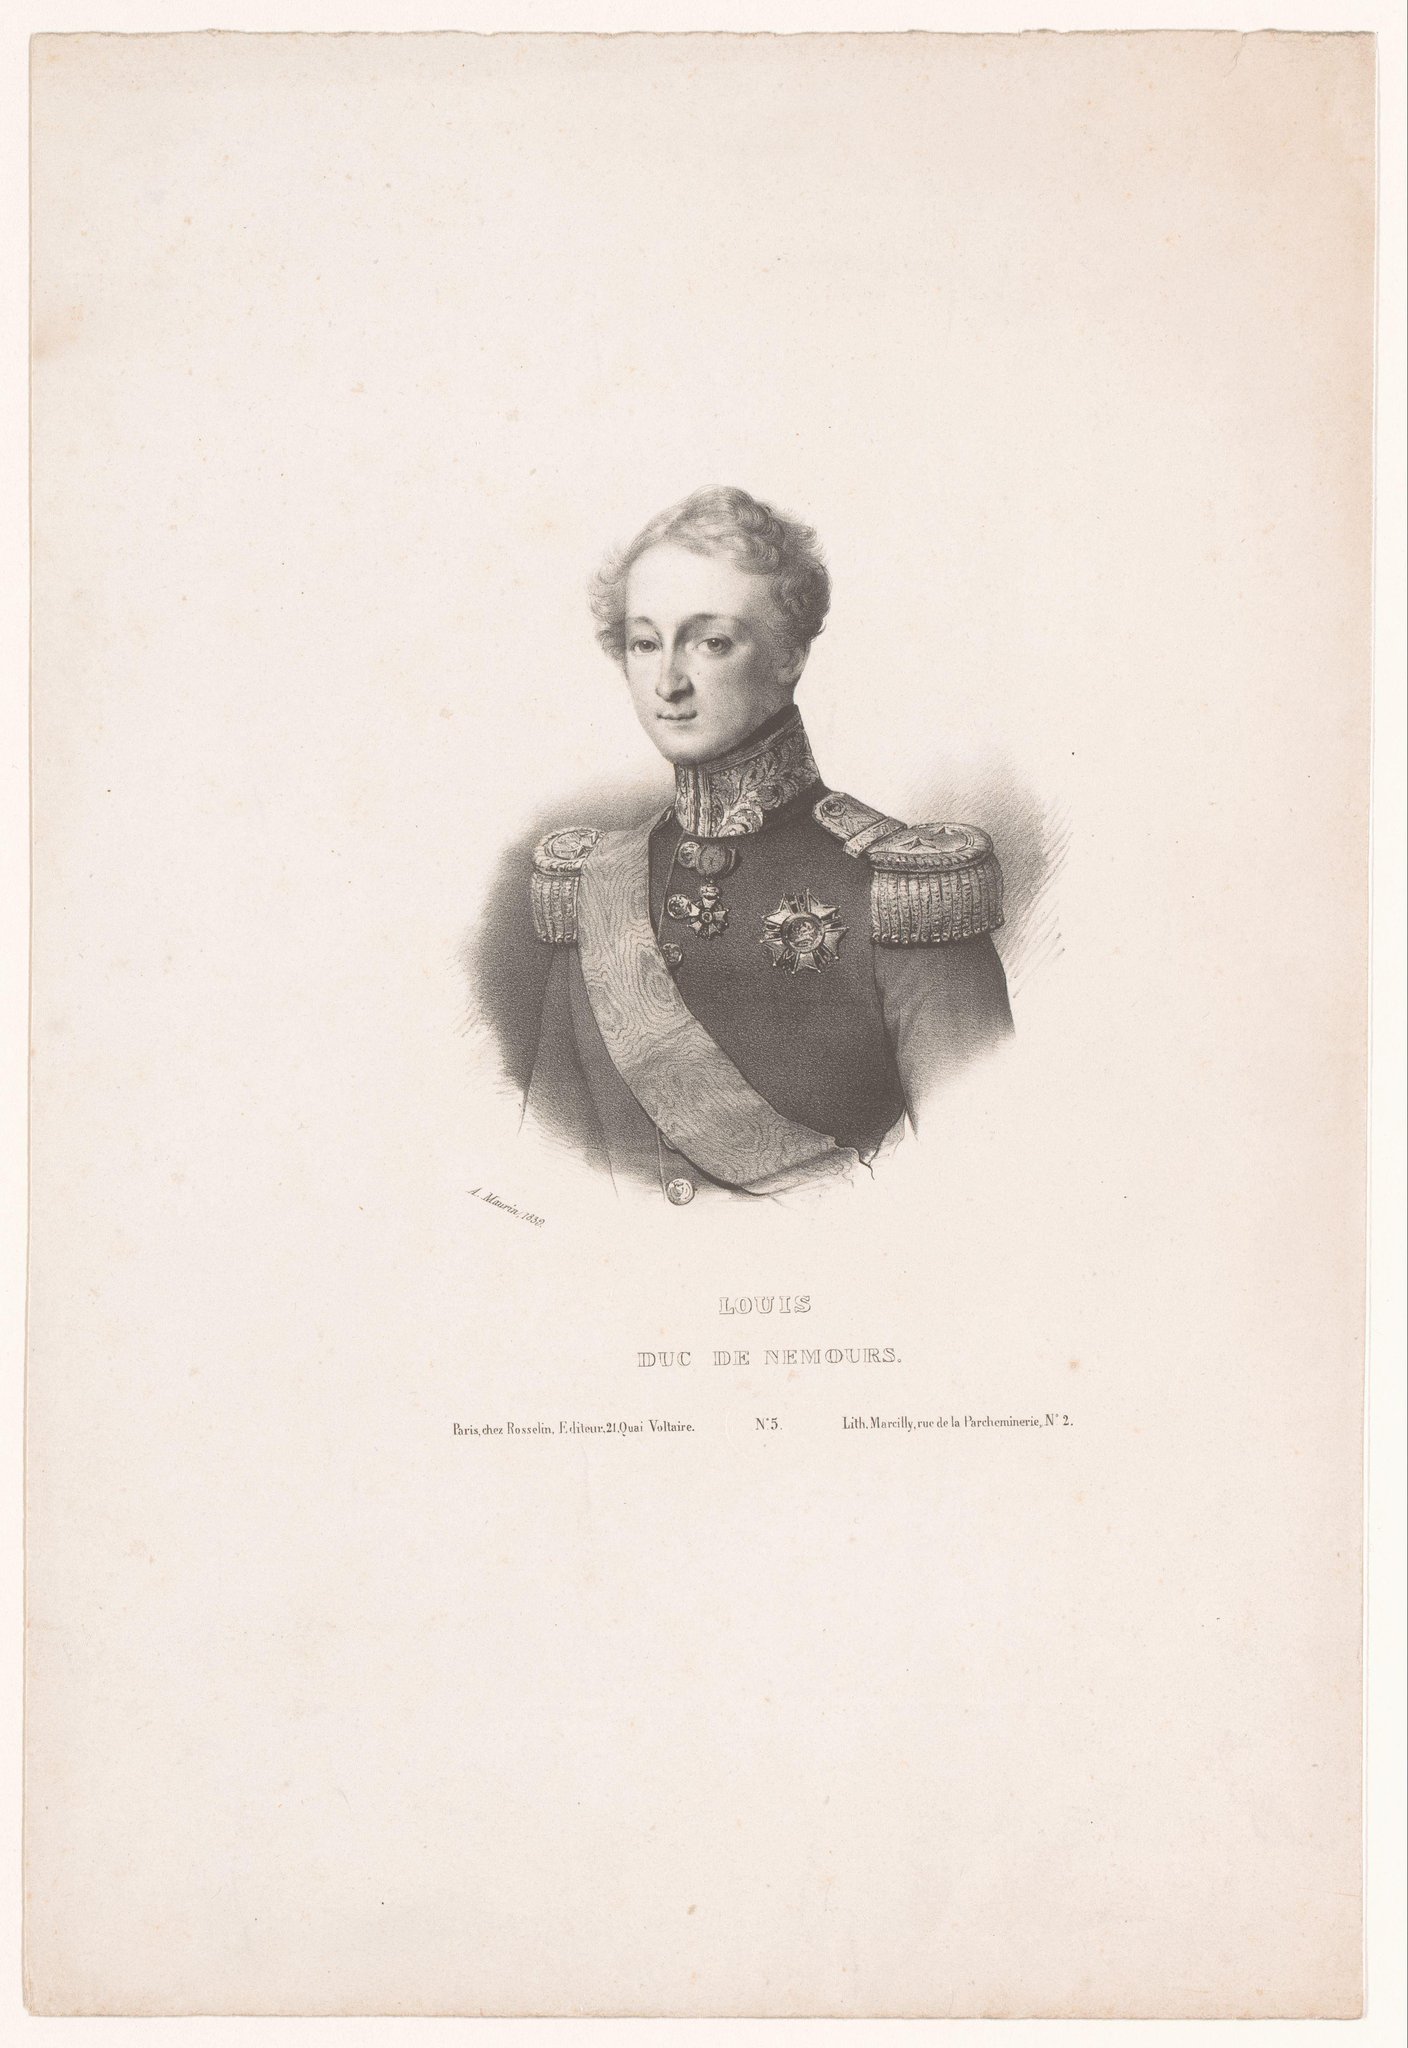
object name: print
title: Louis, duc de Nemours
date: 1839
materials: paper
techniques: lithograph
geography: paris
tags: paris, prince - bb - female ruler, historical persons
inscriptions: collector's mark: Lugt 2228, check stamp: Lugt 3693